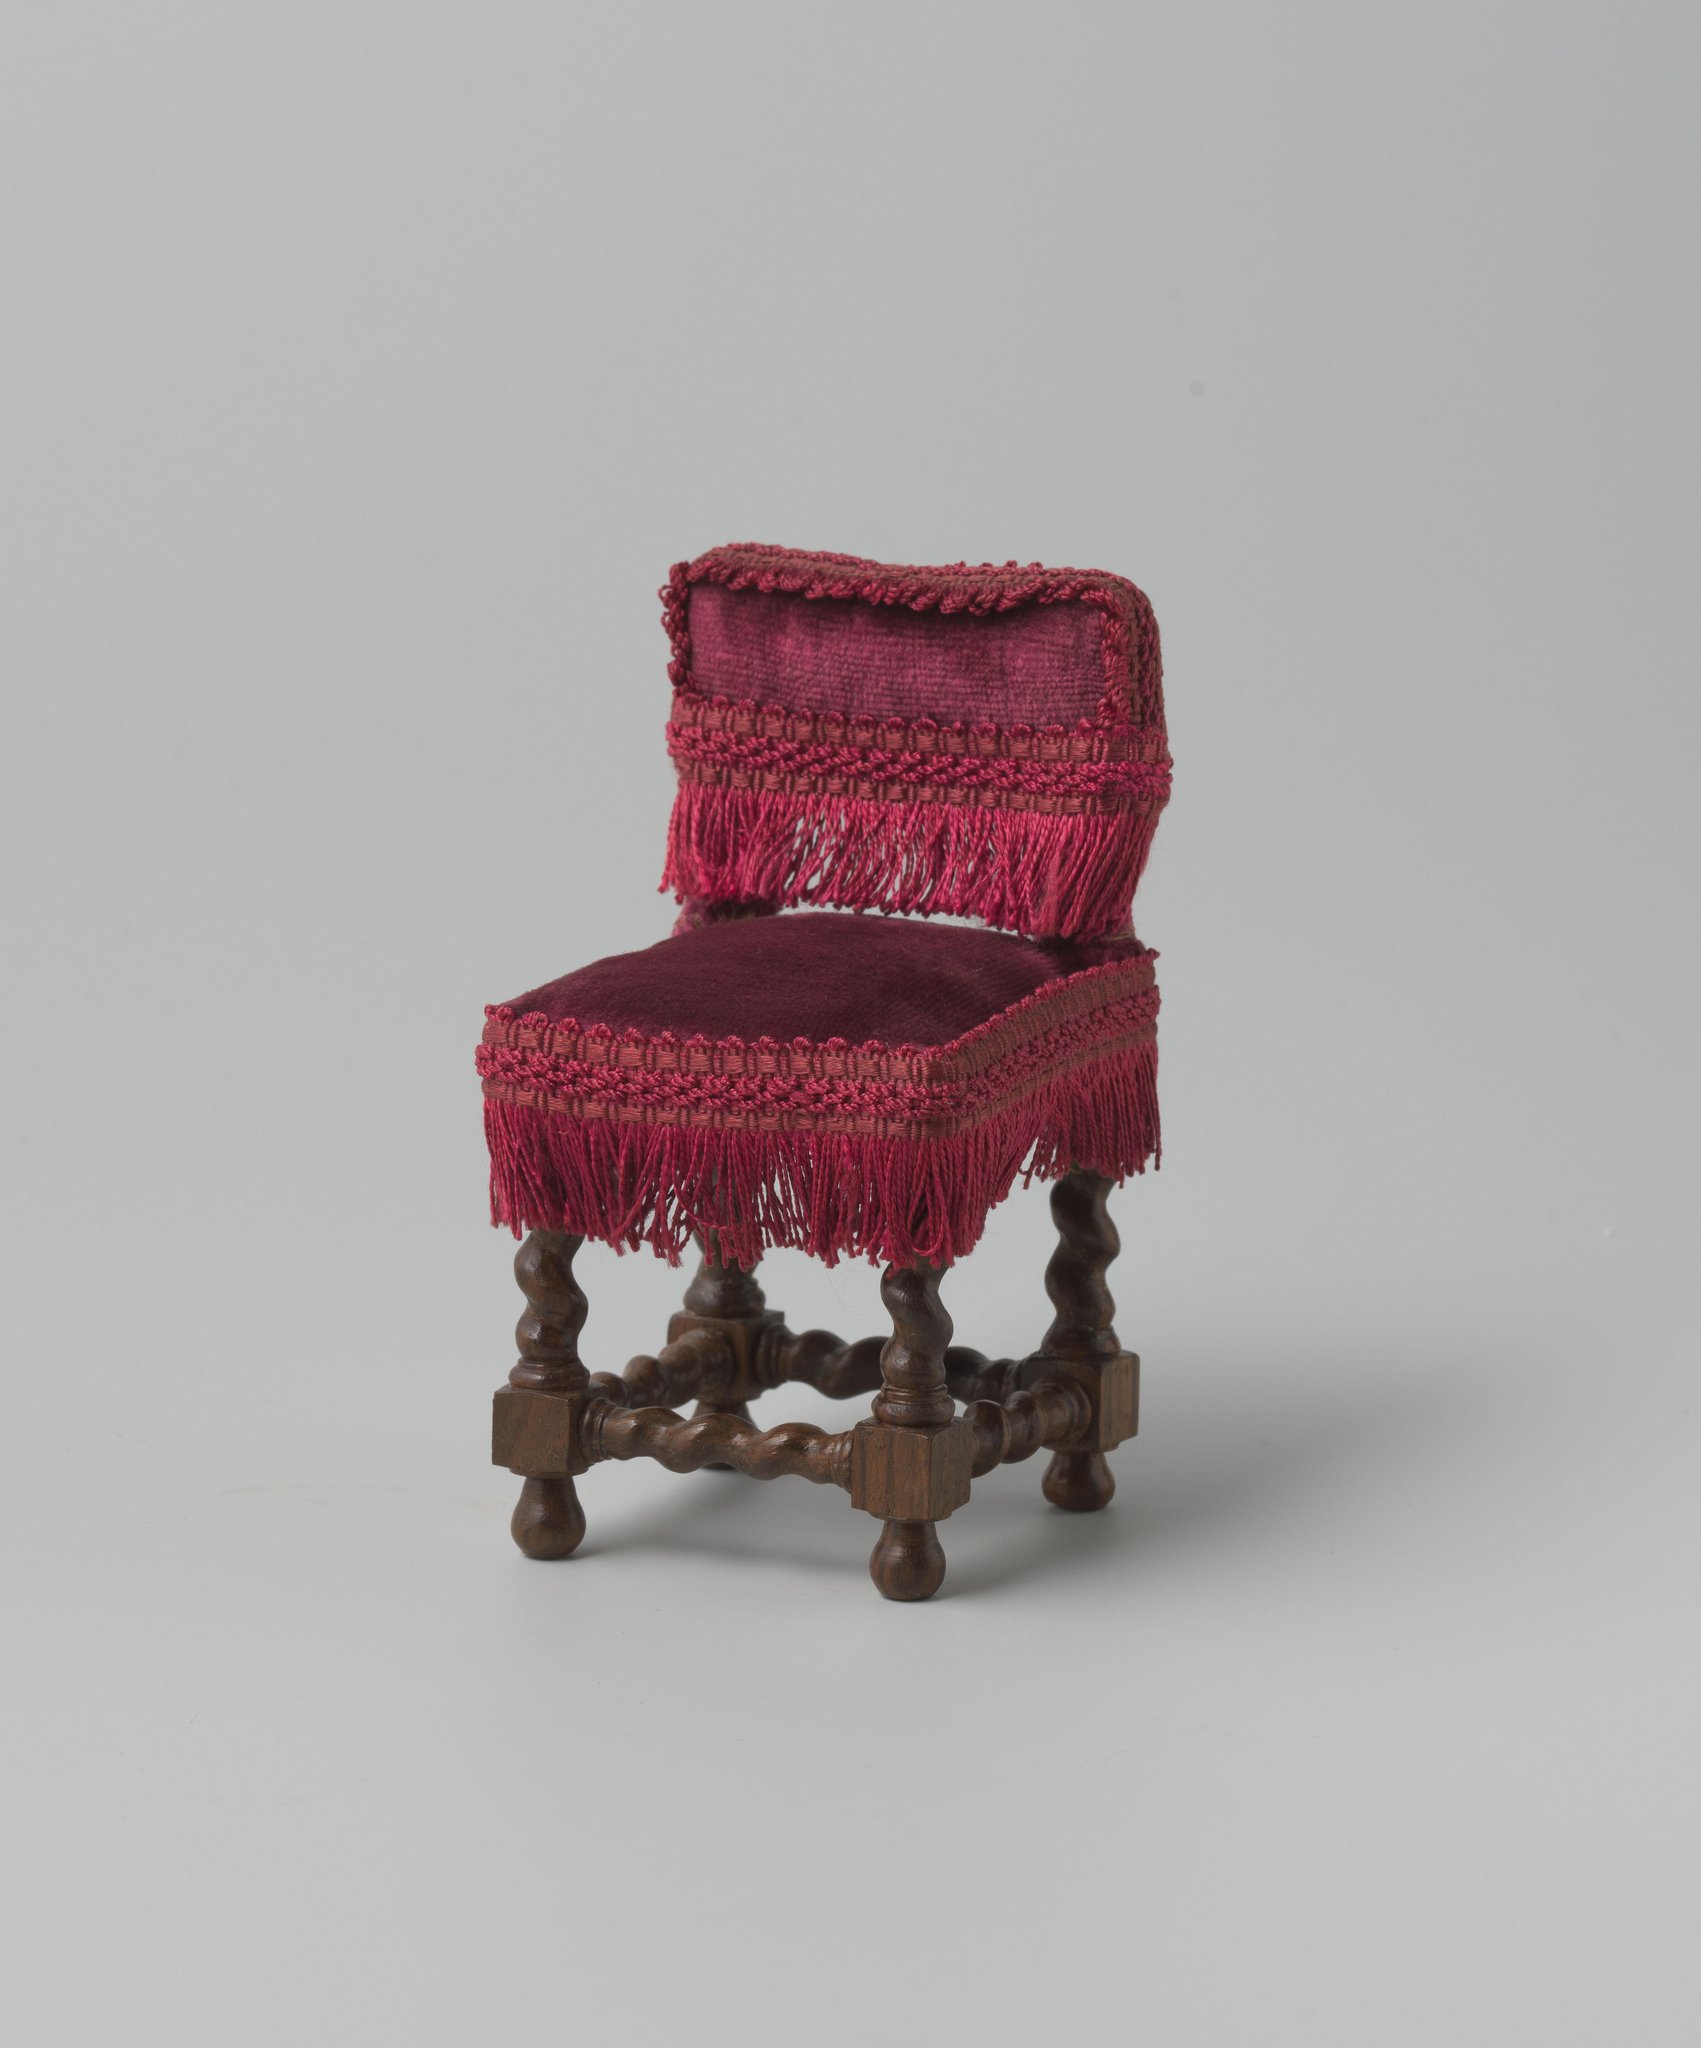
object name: chair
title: Stoel van notenhout, bekleed met rood fluweel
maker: Anonymous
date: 1676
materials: linen, silk, wood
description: Stoel van notenhout met getorste poten en dwarssporten, met elkaar verbonden in huizen, lage rugleuning, vervaardigd uit een stuk notenhout. De zitting en rug bekleed met bordeaurode zijdefluweel, afgezet met smal, zijden passement met lussen en breder passement met losse franje. Zitting gevuld op linnen onderlaag. Achterstijl tussen zitting en rug eveneens bekleed met fluweel.